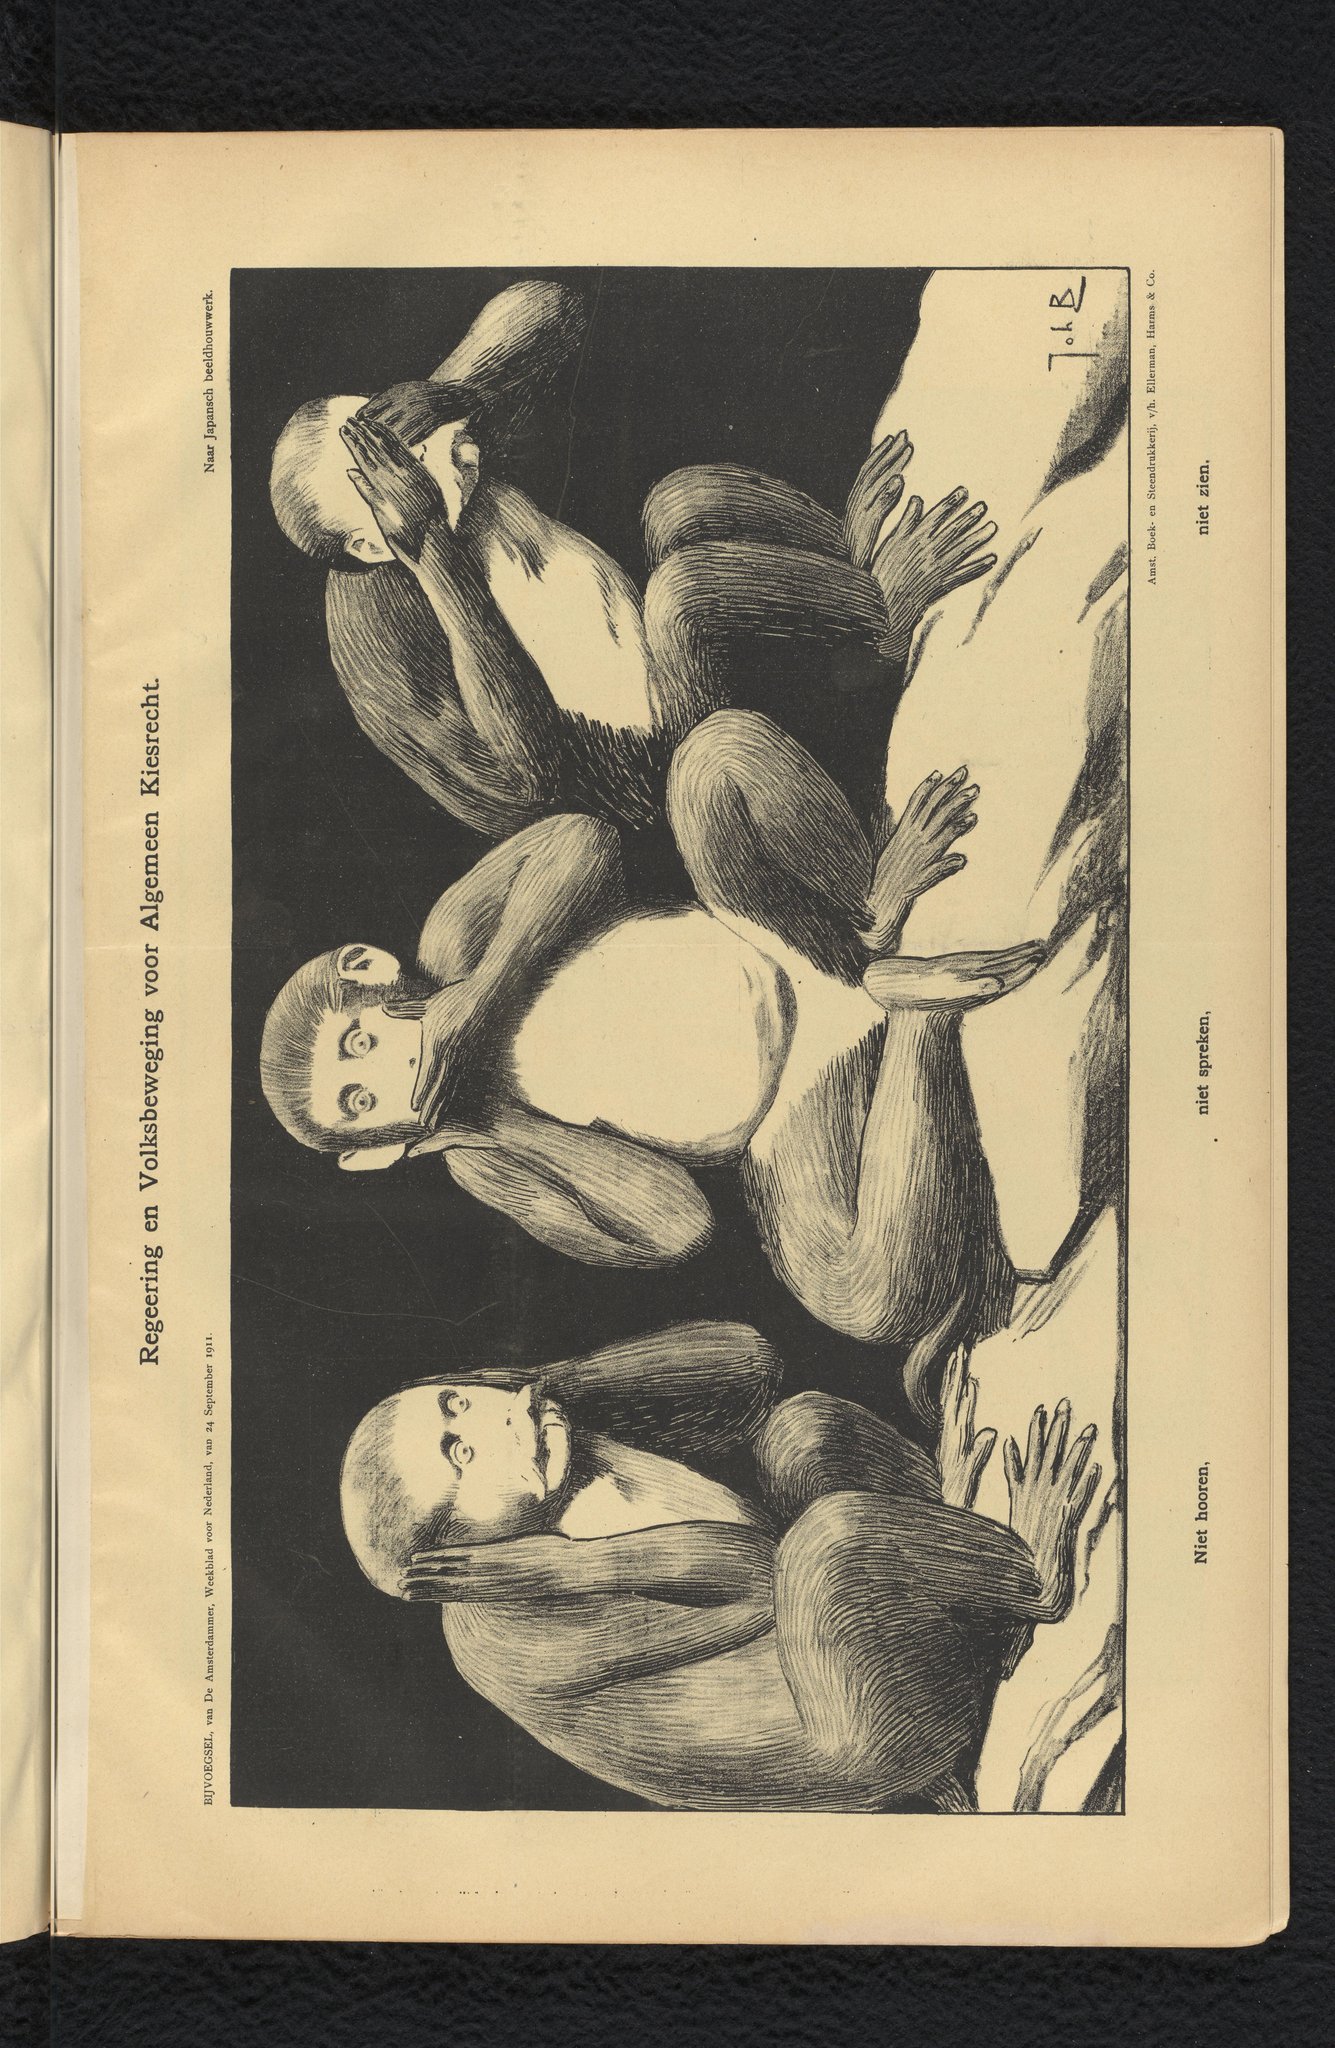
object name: cartoon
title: Regeering en Volksbeweging voor Algemeen Kiesrecht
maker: johan braakensiek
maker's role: draughtsman, print maker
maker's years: 1858-1940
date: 1911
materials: paper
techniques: lithograph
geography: amsterdam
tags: monkeys, apes, the right to vote, the compulsory vote, political caricatures and satires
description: Drie apen die 'niet horen', 'niet spreken' en 'niet zien'. Naar aanleiding van de discussie rond de invoering van het Algemeen Kiesrecht.